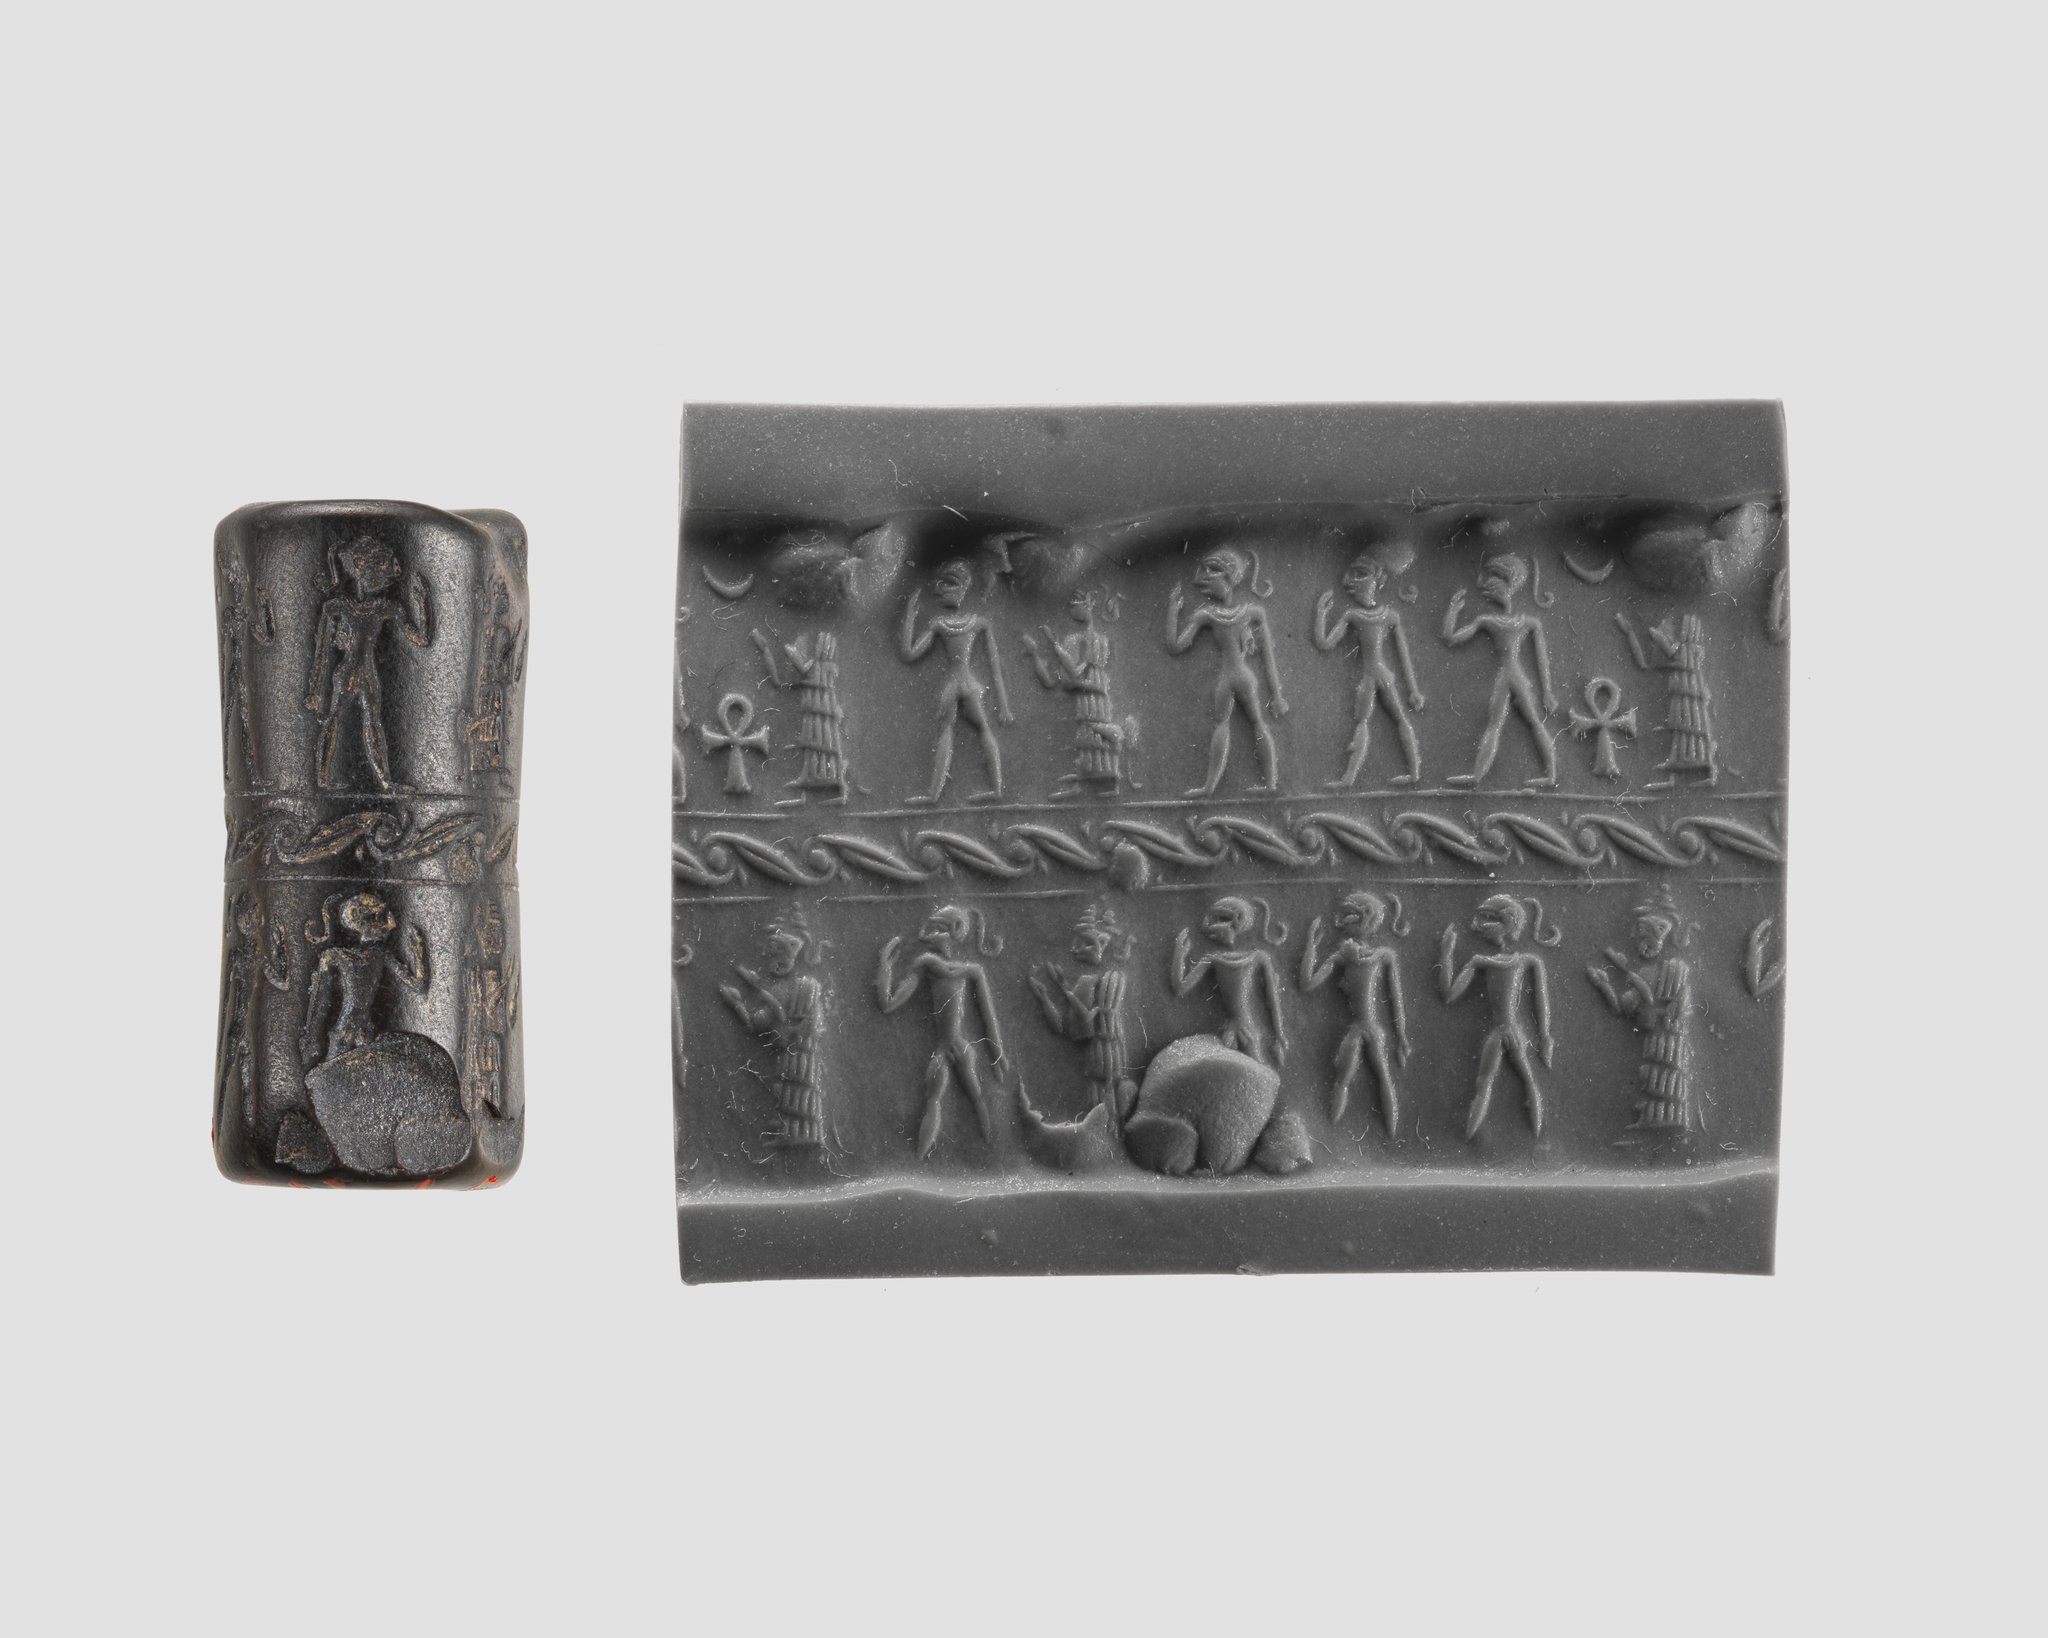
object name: cylinder seal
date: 1820-1730 BCE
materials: mineral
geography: syria